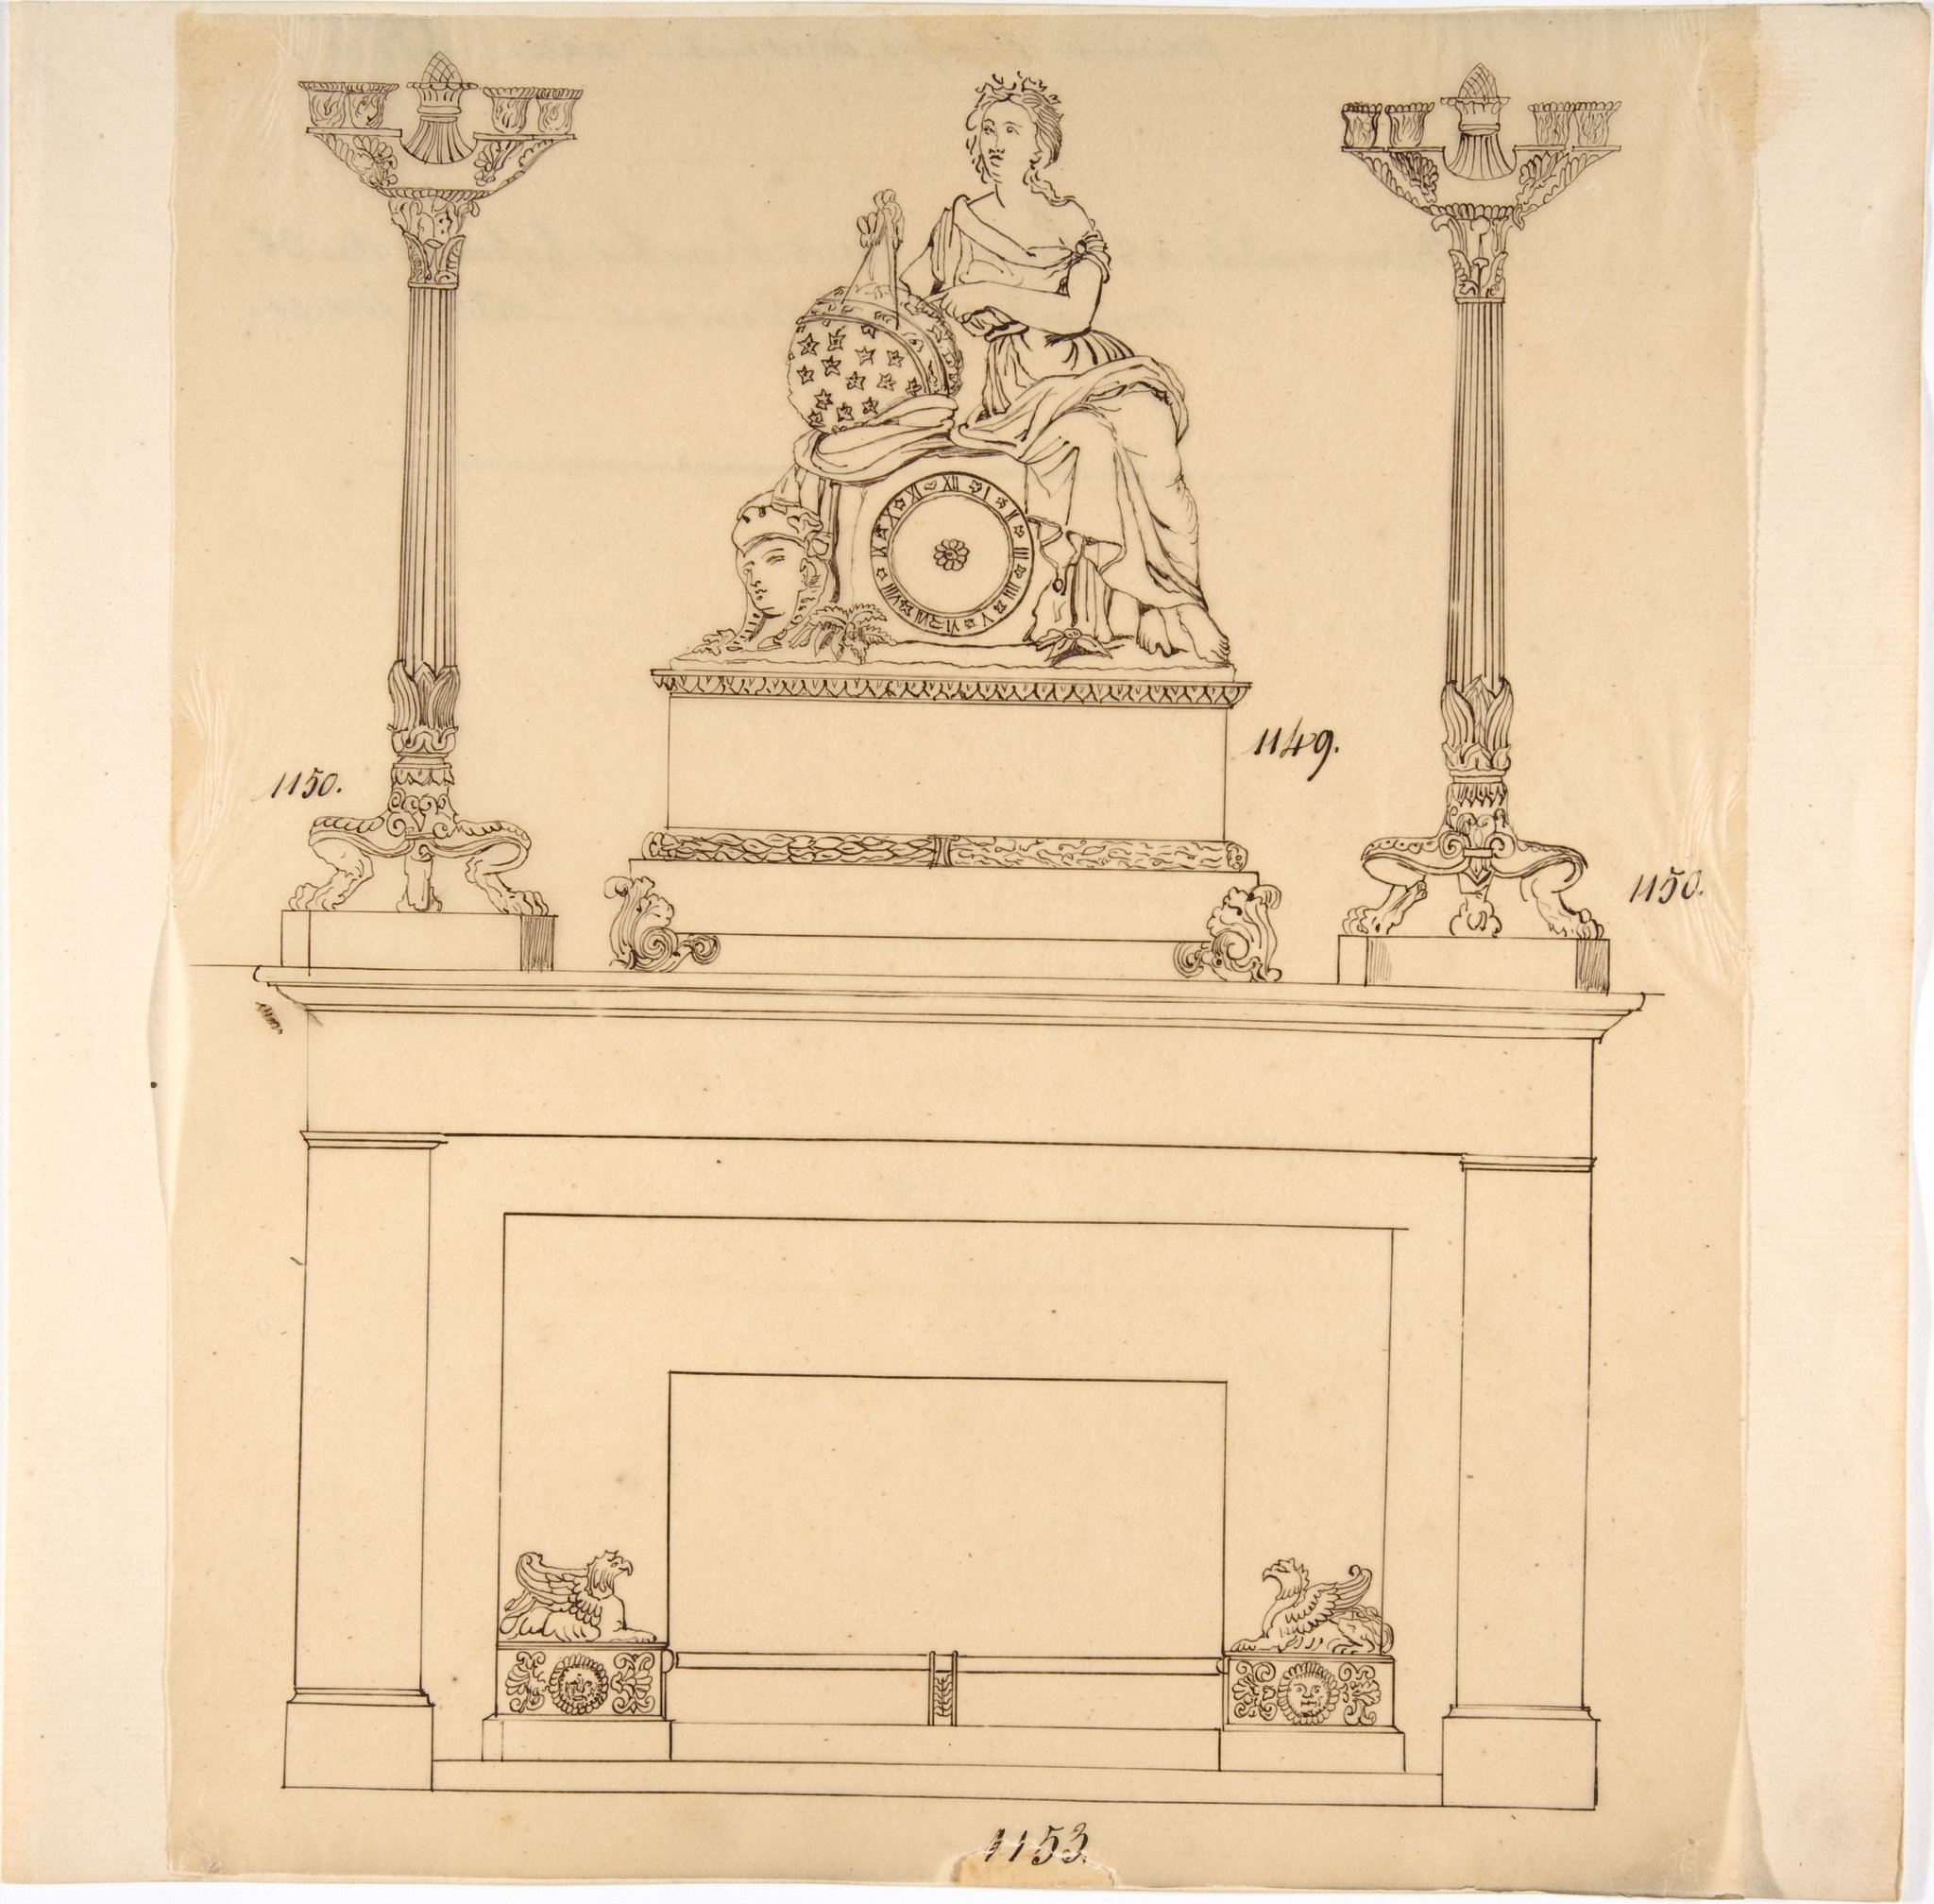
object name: drawing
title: Designs for Fireplace Iron, Mantle Candlesticks and a Clock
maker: anonymous, french, 19th century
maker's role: artist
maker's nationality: french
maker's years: 1800-1900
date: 1801-1900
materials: ink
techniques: pen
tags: fireplaces,clocks,candlesticks